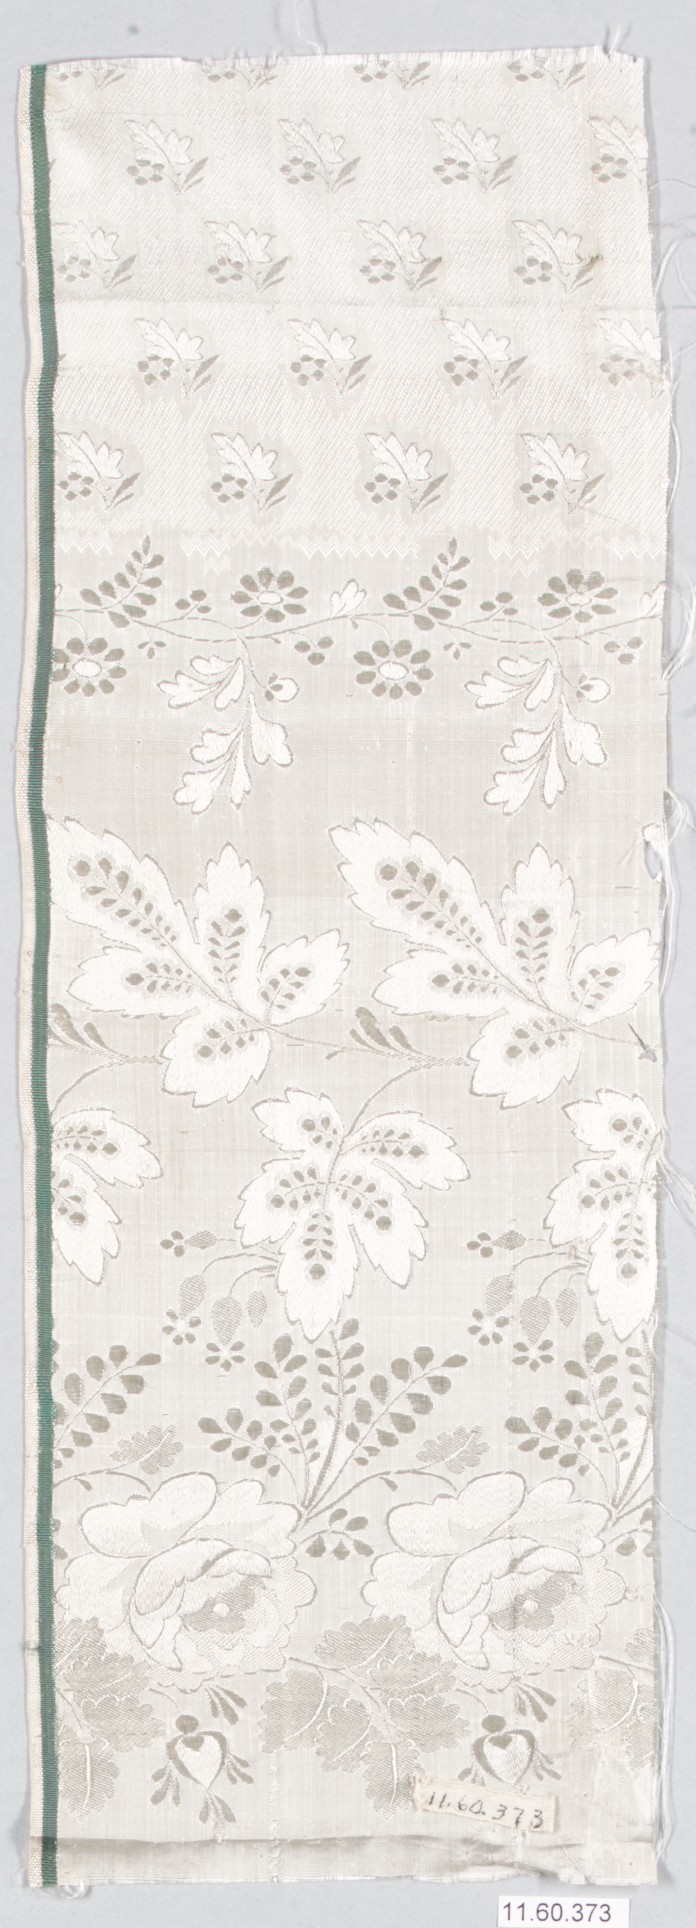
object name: fragment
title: Fragments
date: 1801-1900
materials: silk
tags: flowers,leaves